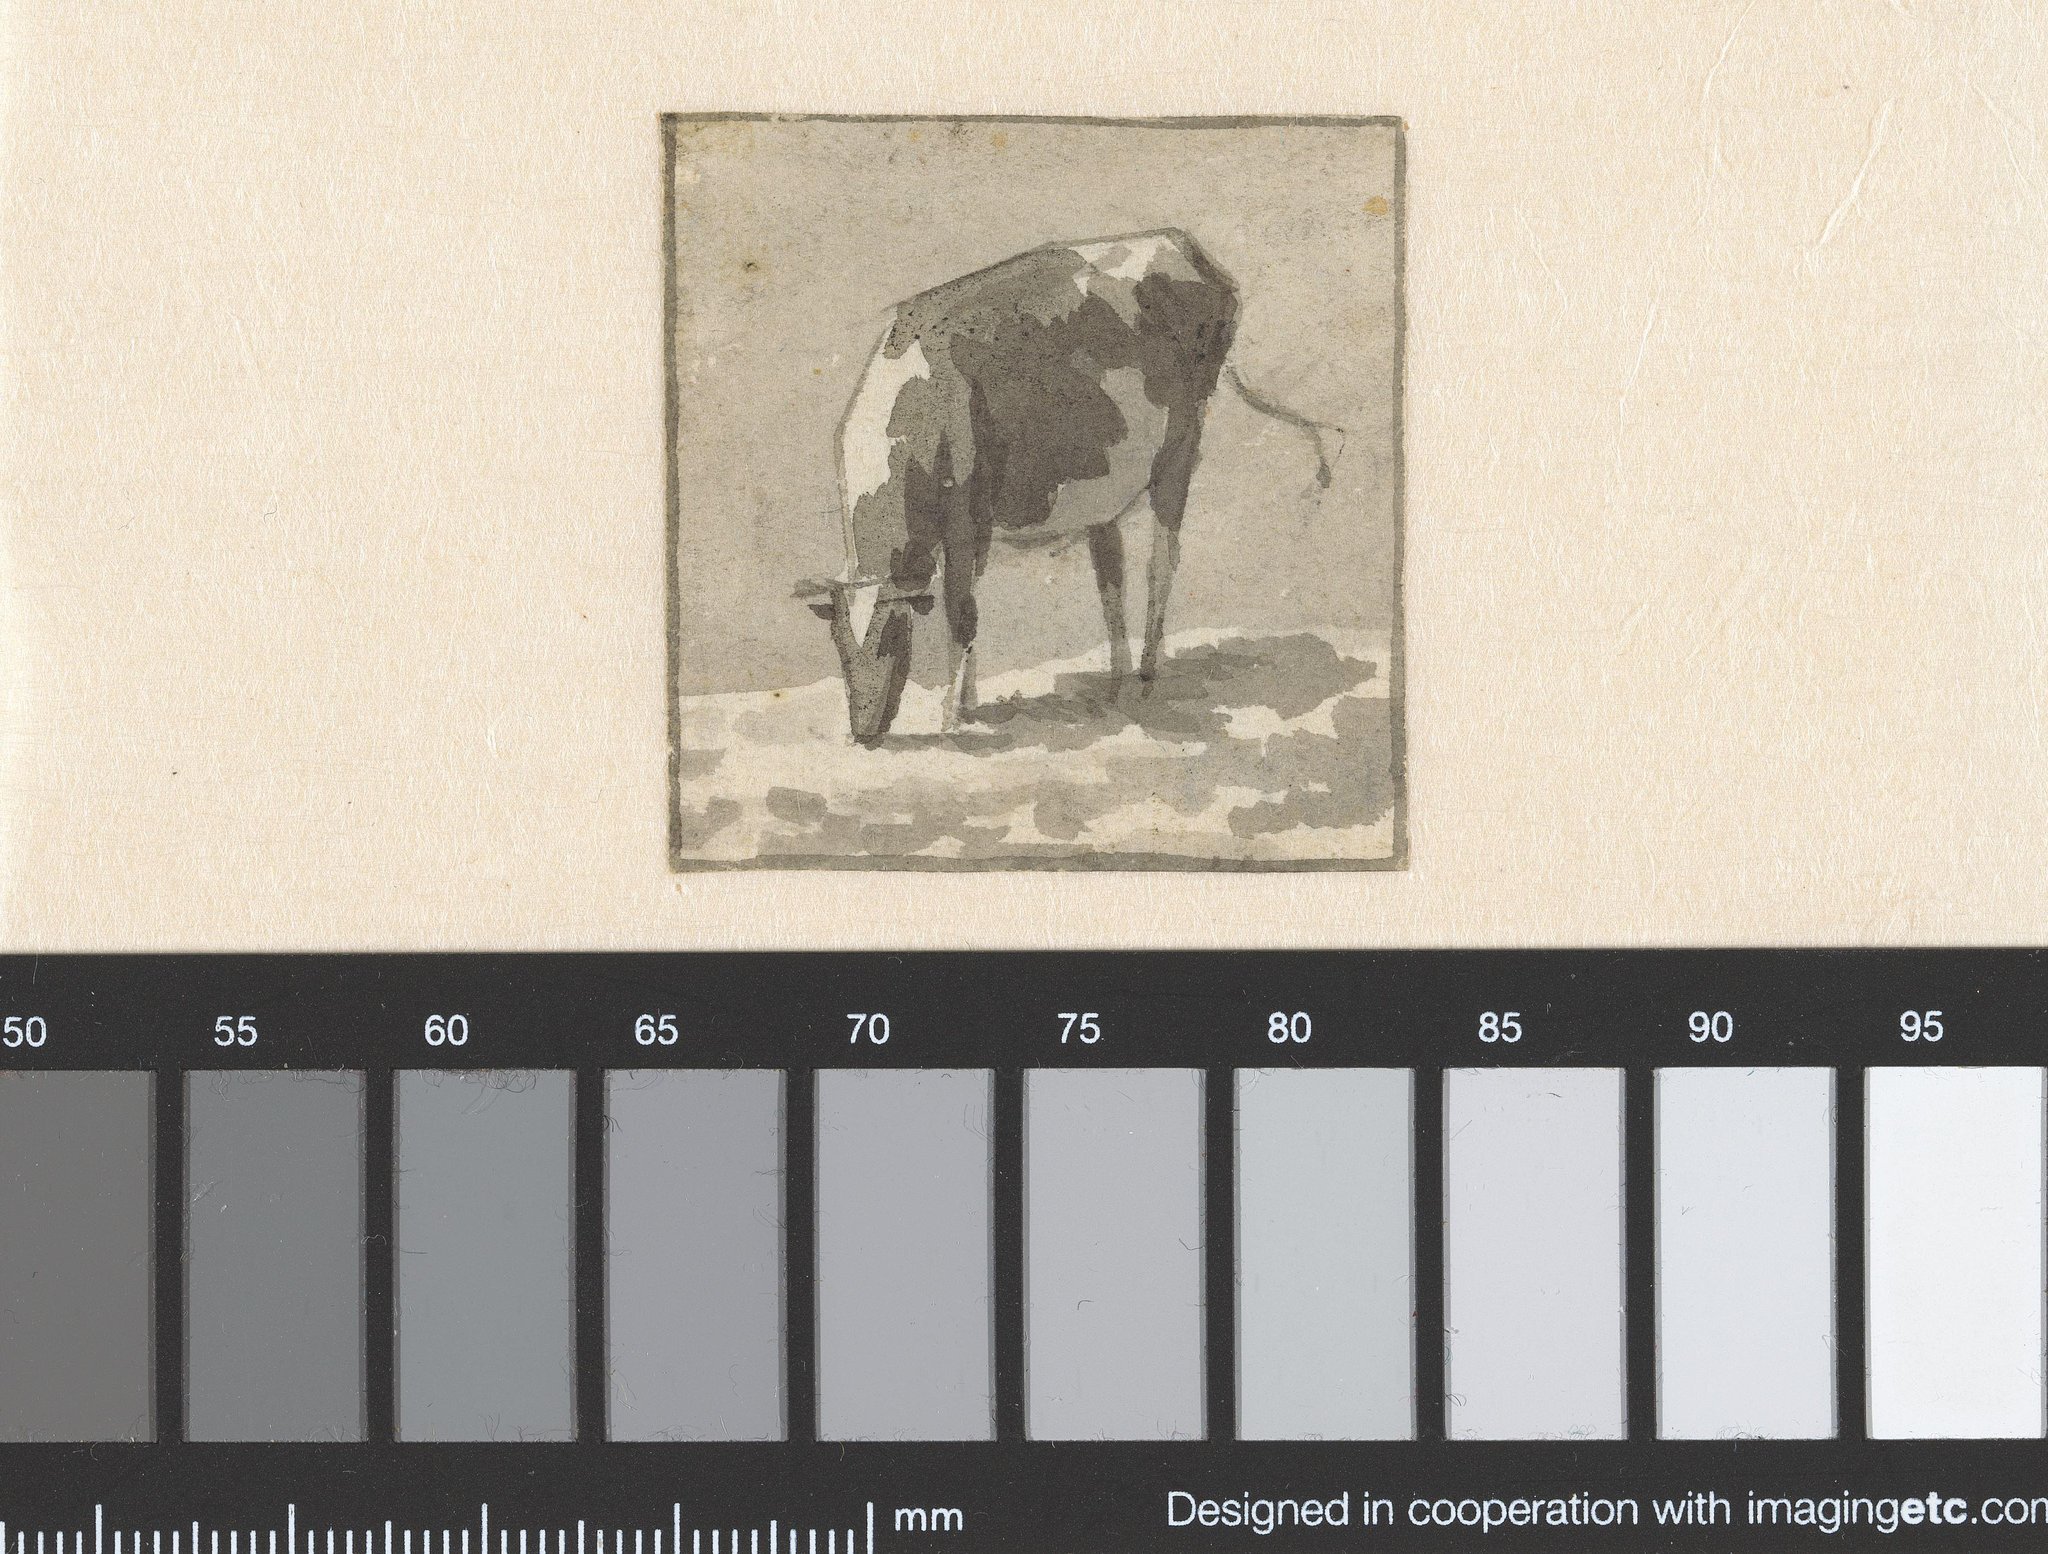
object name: drawing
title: Studie van een grazende koe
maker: wouter johannes van troostwijk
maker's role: draughtsman, painter, print maker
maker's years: 1782-1810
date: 1792-1810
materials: ink, paper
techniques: brush, pen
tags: cow